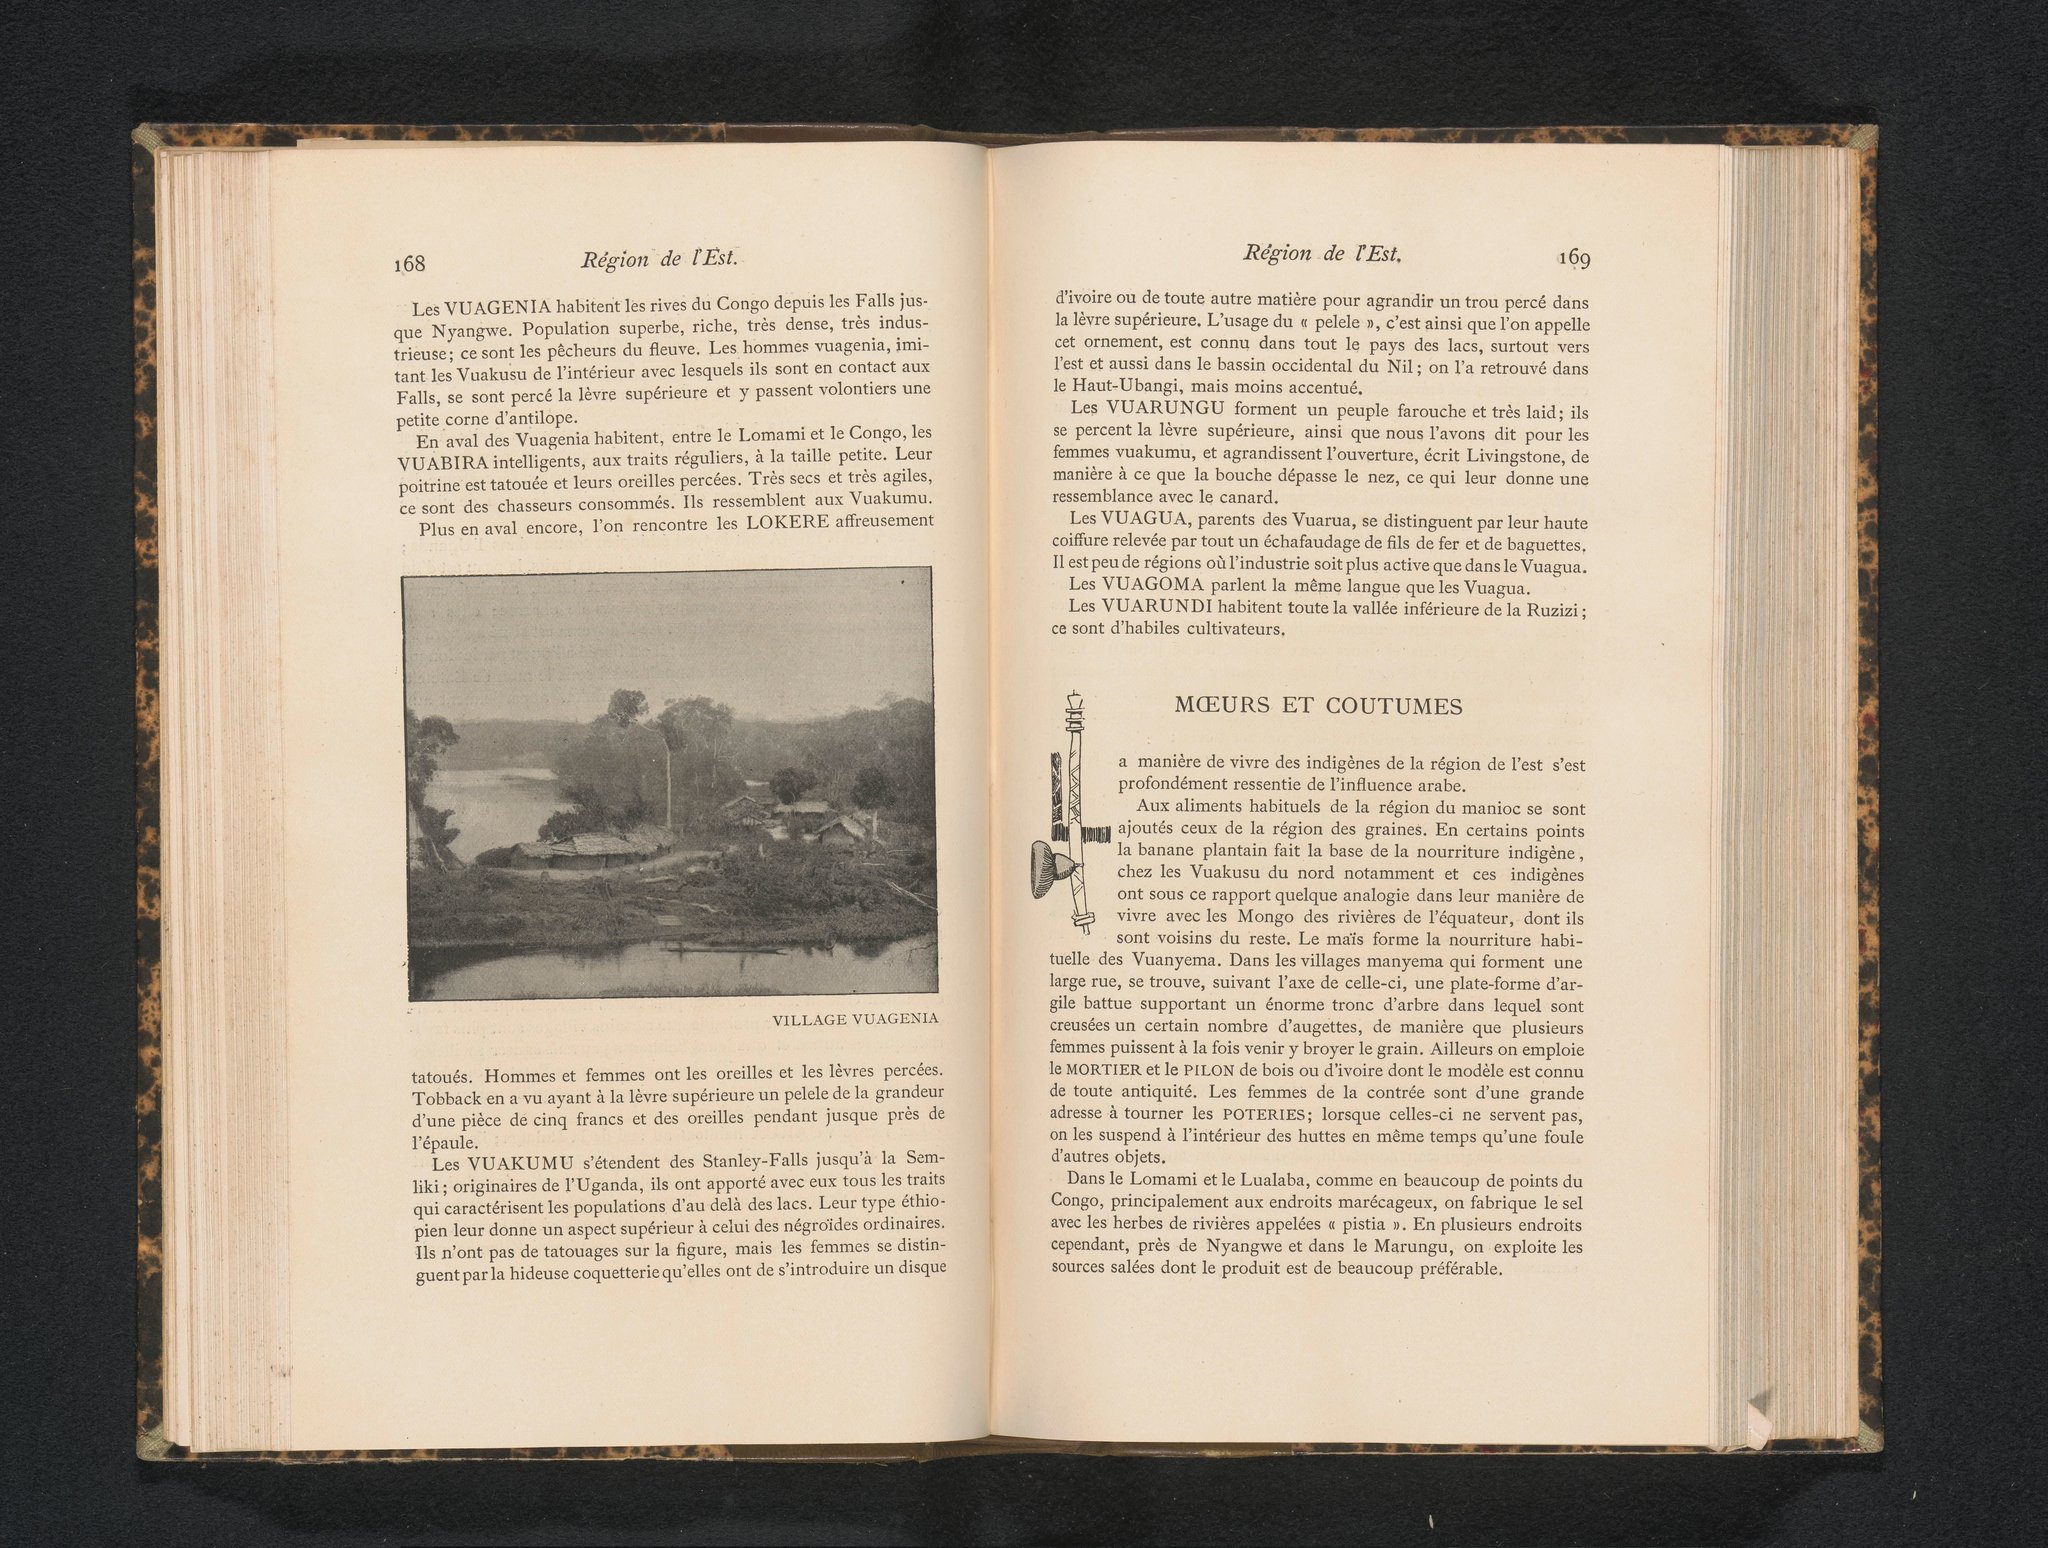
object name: photomechanical print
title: Gezicht op Vuagenia, Congo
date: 1887-1892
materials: paper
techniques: autotype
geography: congo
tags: river, village